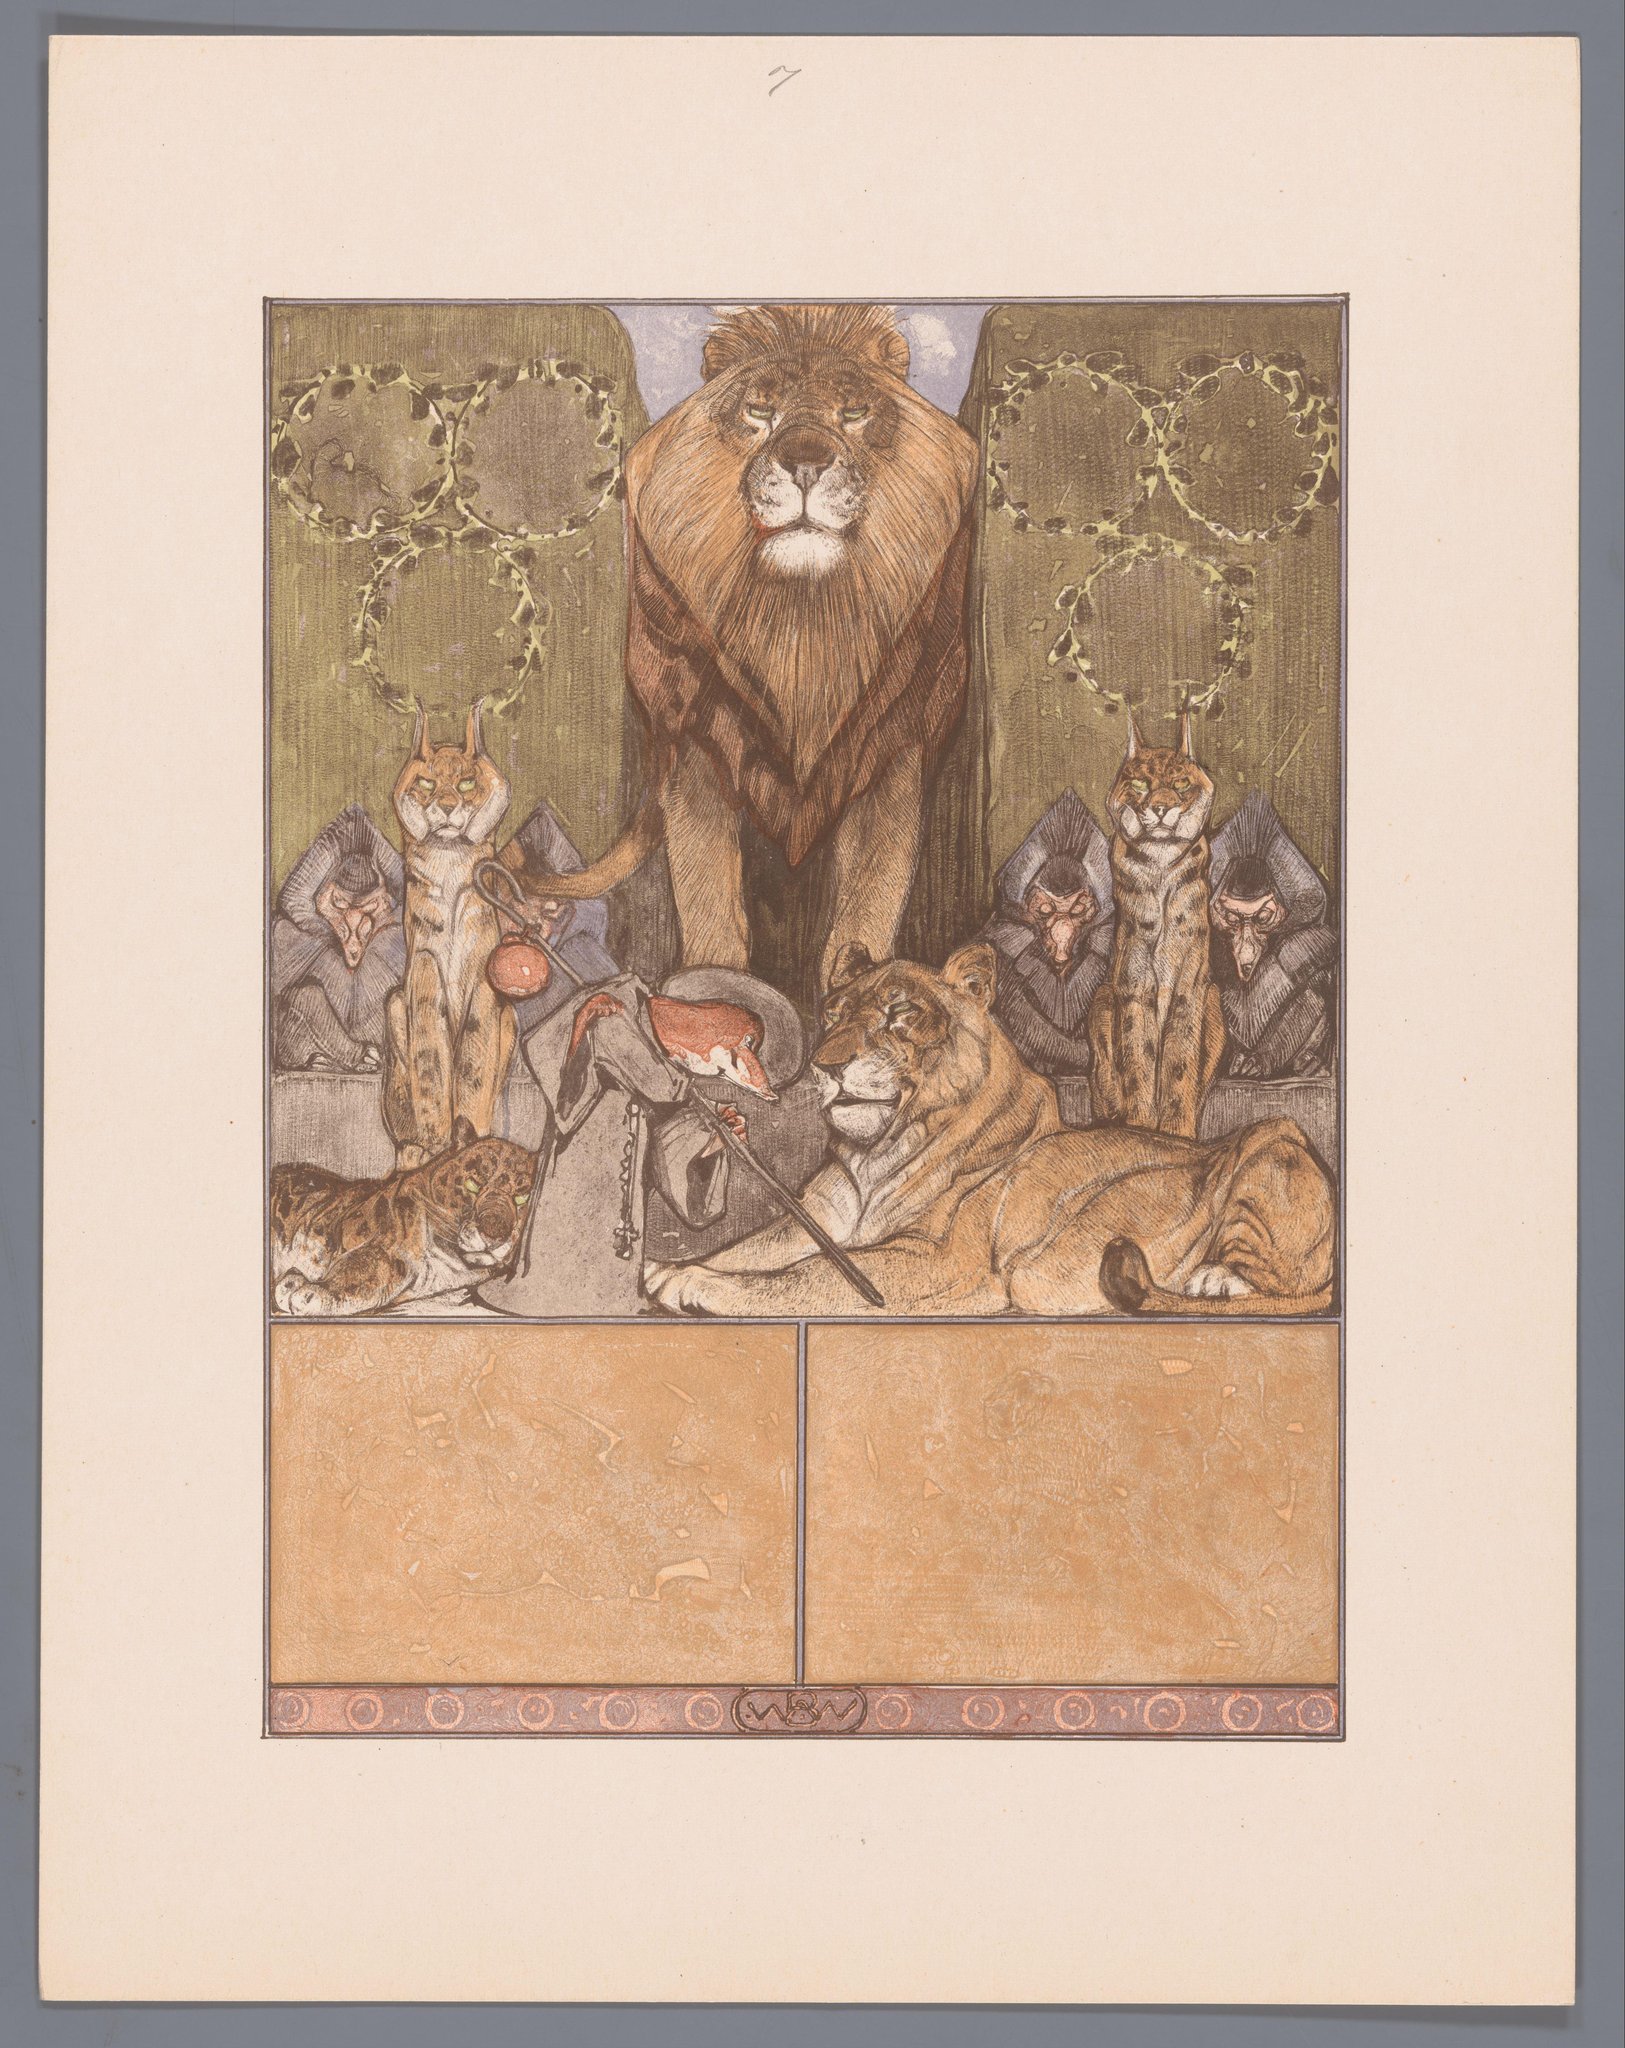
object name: print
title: Vos in monnikspij (Reinaert) aan voeten van leeuw (Nobel) en leeuwin (Gentel), temidden van andere dieren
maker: bernard willem wierink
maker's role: draughtsman, print maker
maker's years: 1856-1939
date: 1910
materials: paper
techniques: lithograph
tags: fable of reynard the fox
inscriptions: collector's mark: Lugt 2228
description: Ontwerp voor: Streuvels, Stijn (Frank Lateur). Reinaert de Vos naar verschillende uitgaven van het middeleeuwsche epos. Amsterdam: L.J. Veen, 1910.